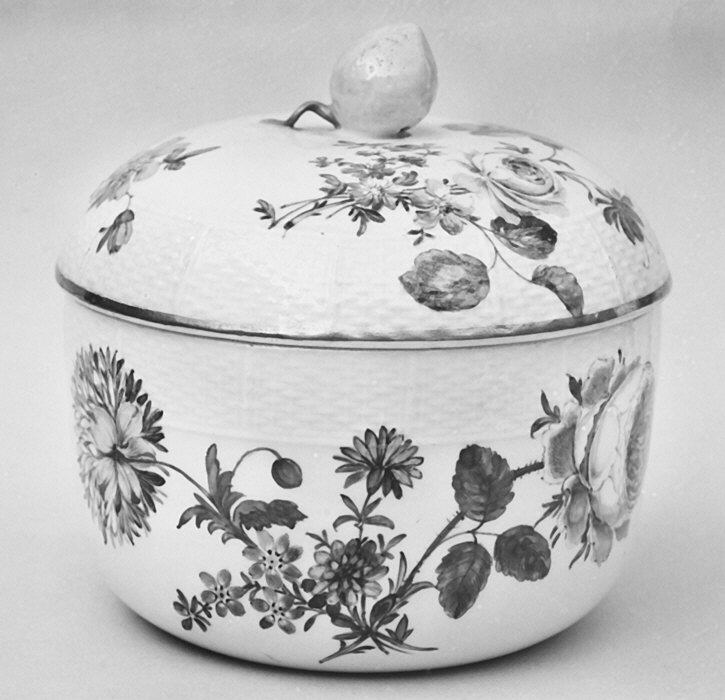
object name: bowl with cover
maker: meissen manufactory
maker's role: manufactory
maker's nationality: german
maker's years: 1710-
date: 1750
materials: hard paste porcelain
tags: flowers